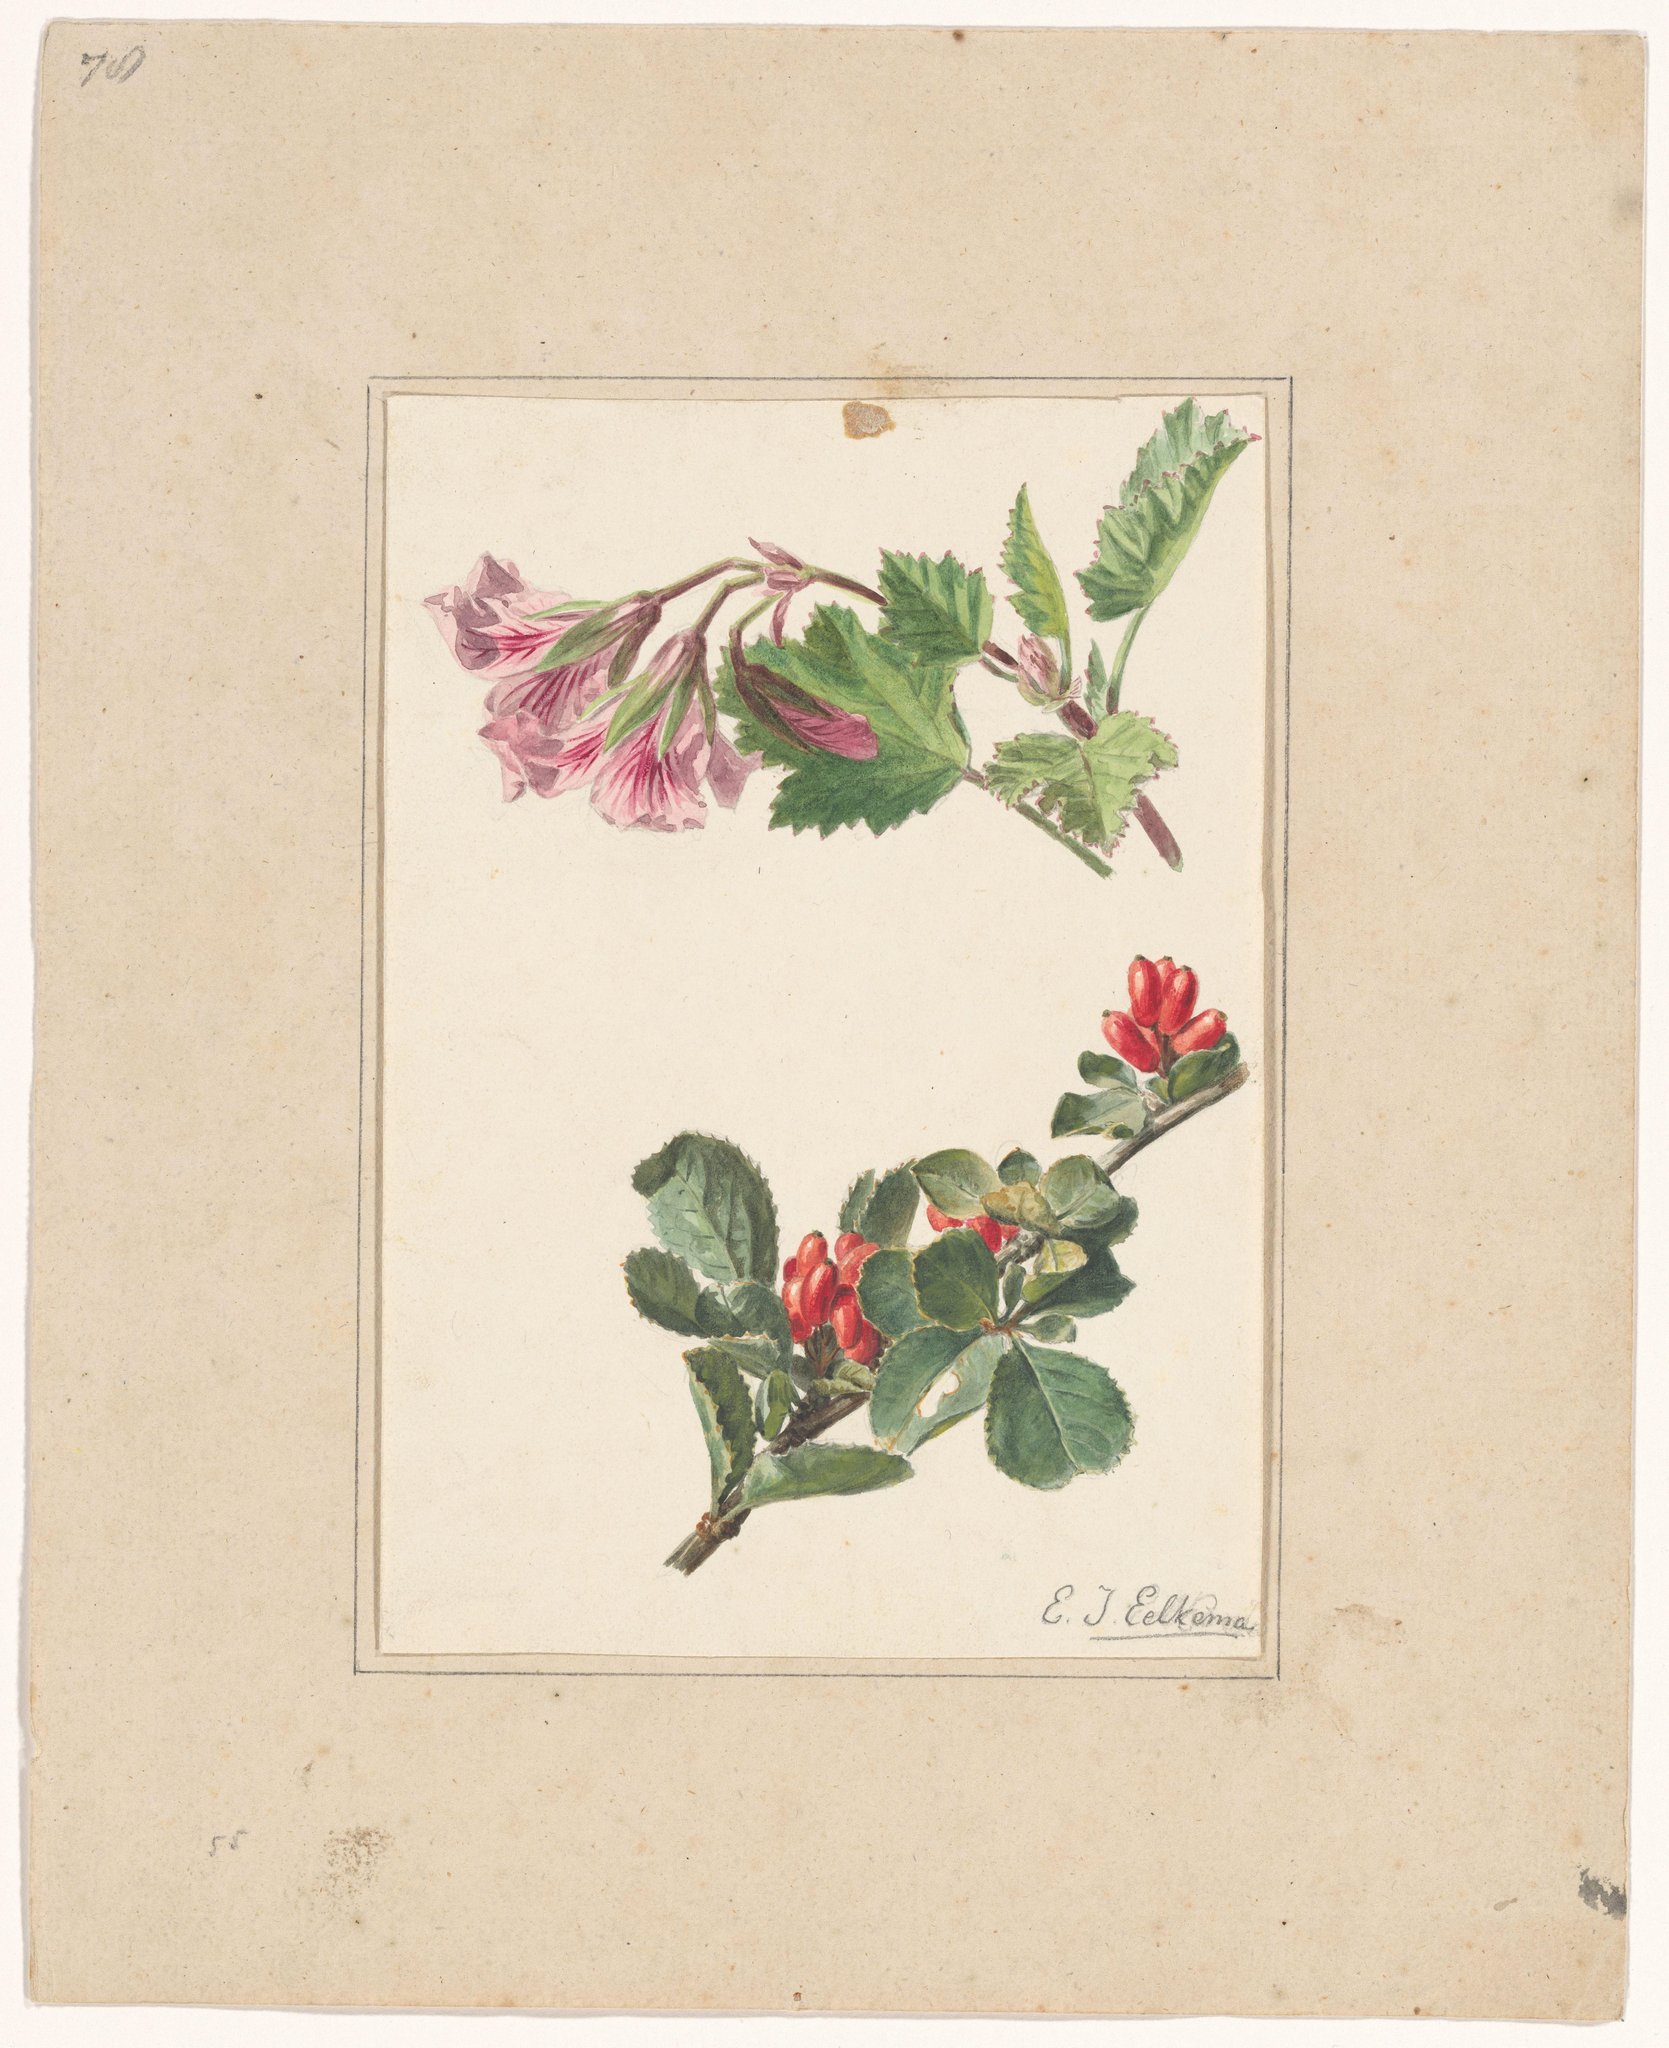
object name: drawing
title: Rimpelroos?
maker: eelke jelles eelkema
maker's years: 1788-1839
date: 1815-1830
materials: paper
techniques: drawing